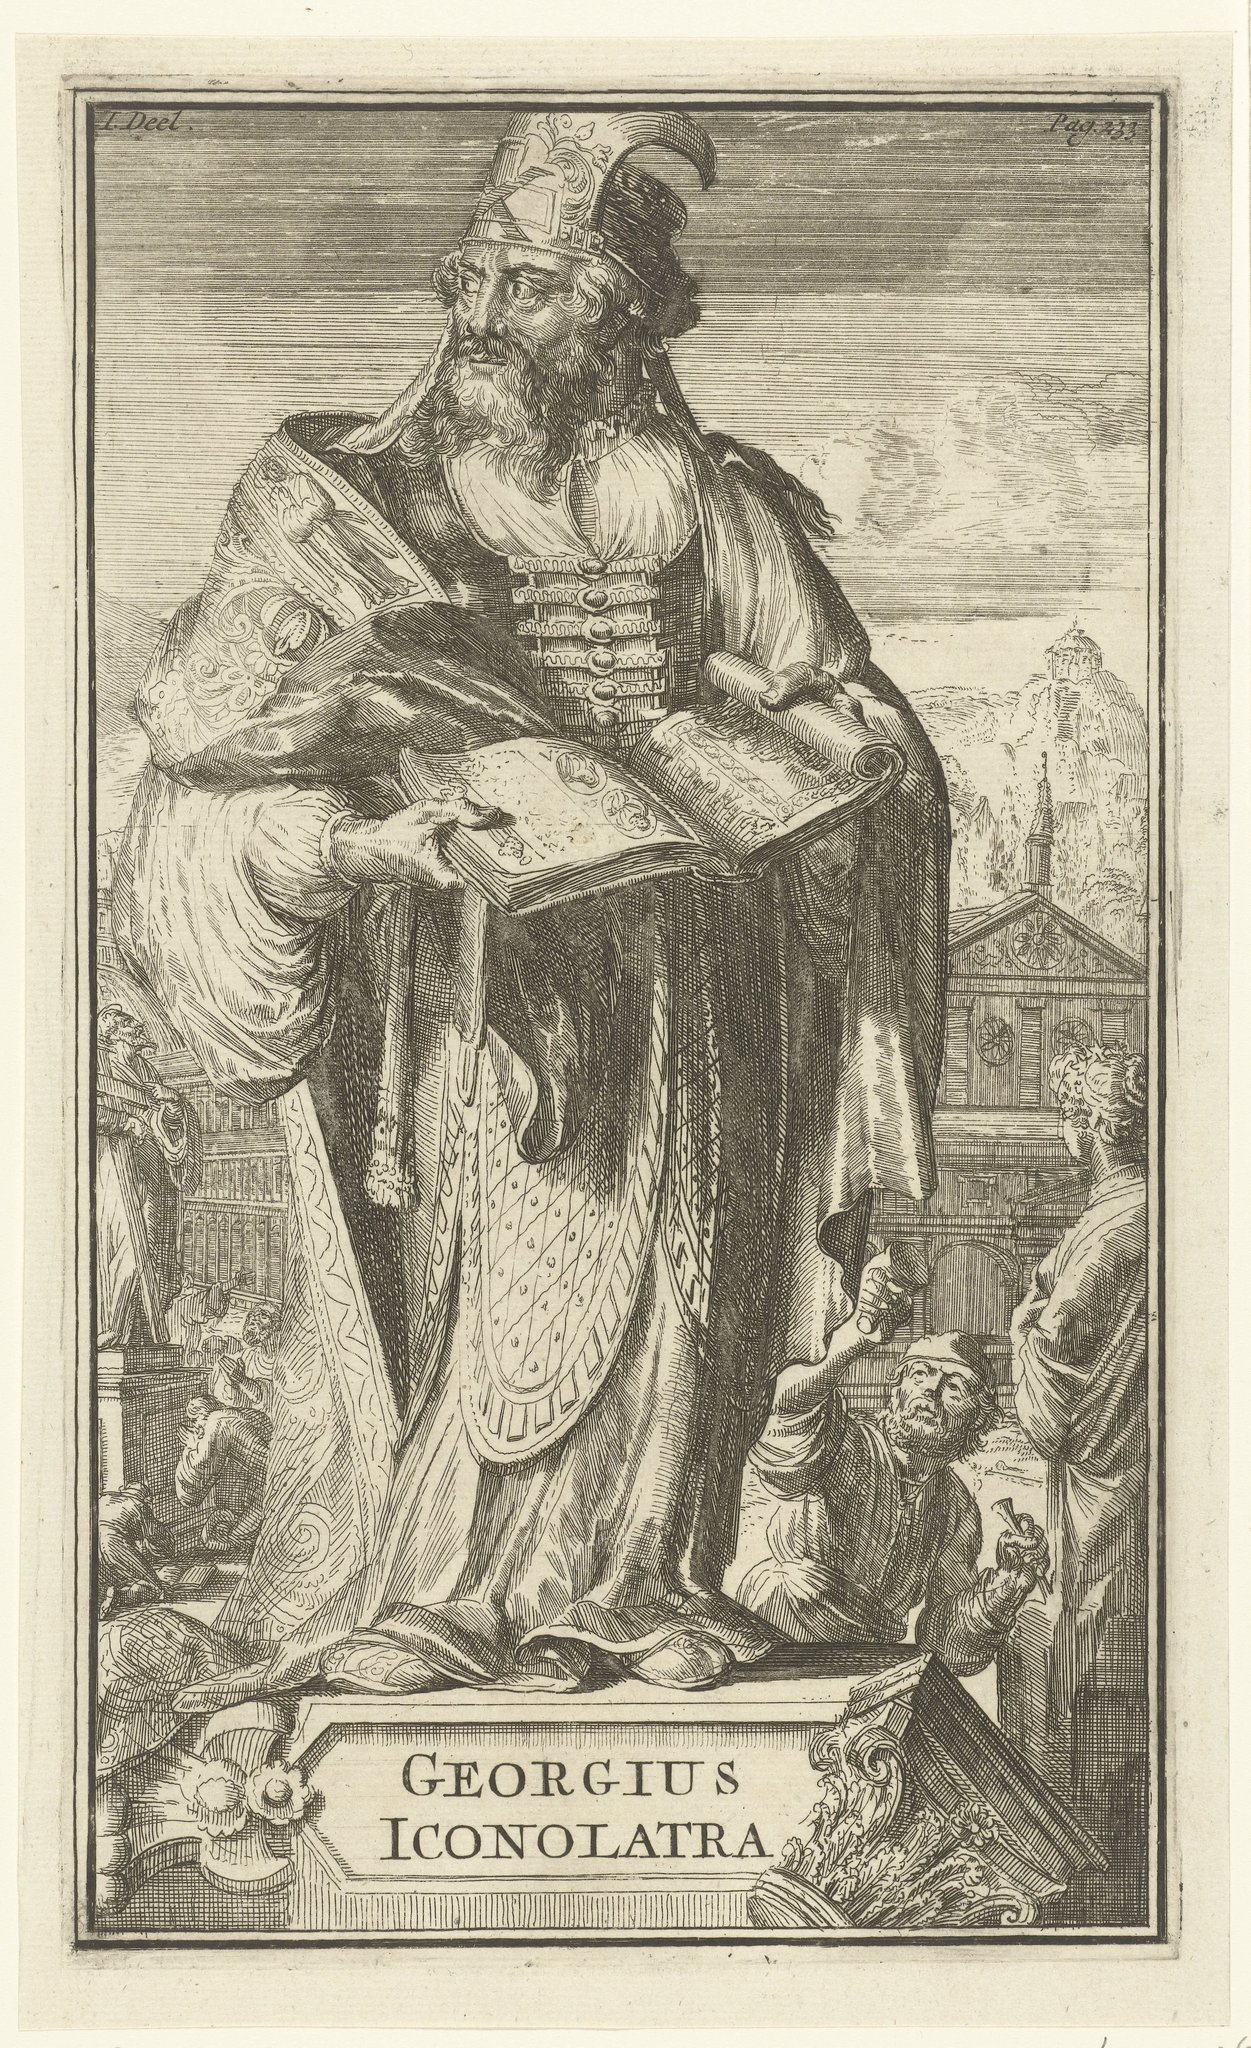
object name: print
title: Georgius Iconolatra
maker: romeyn de hooghe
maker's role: draughtsman, goldsmith, painter, print maker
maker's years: 1645-1708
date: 1701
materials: paper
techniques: engraving, etching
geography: netherlands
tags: georgius iconolatra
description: Portret van Georgius Iconolatra uit een serie portretten in Historie der Kerken en ketteren van den beginne des Nieuwen Testaments tot aan het jaar onses Heeren 1688 van Godfried Arnold (1701).